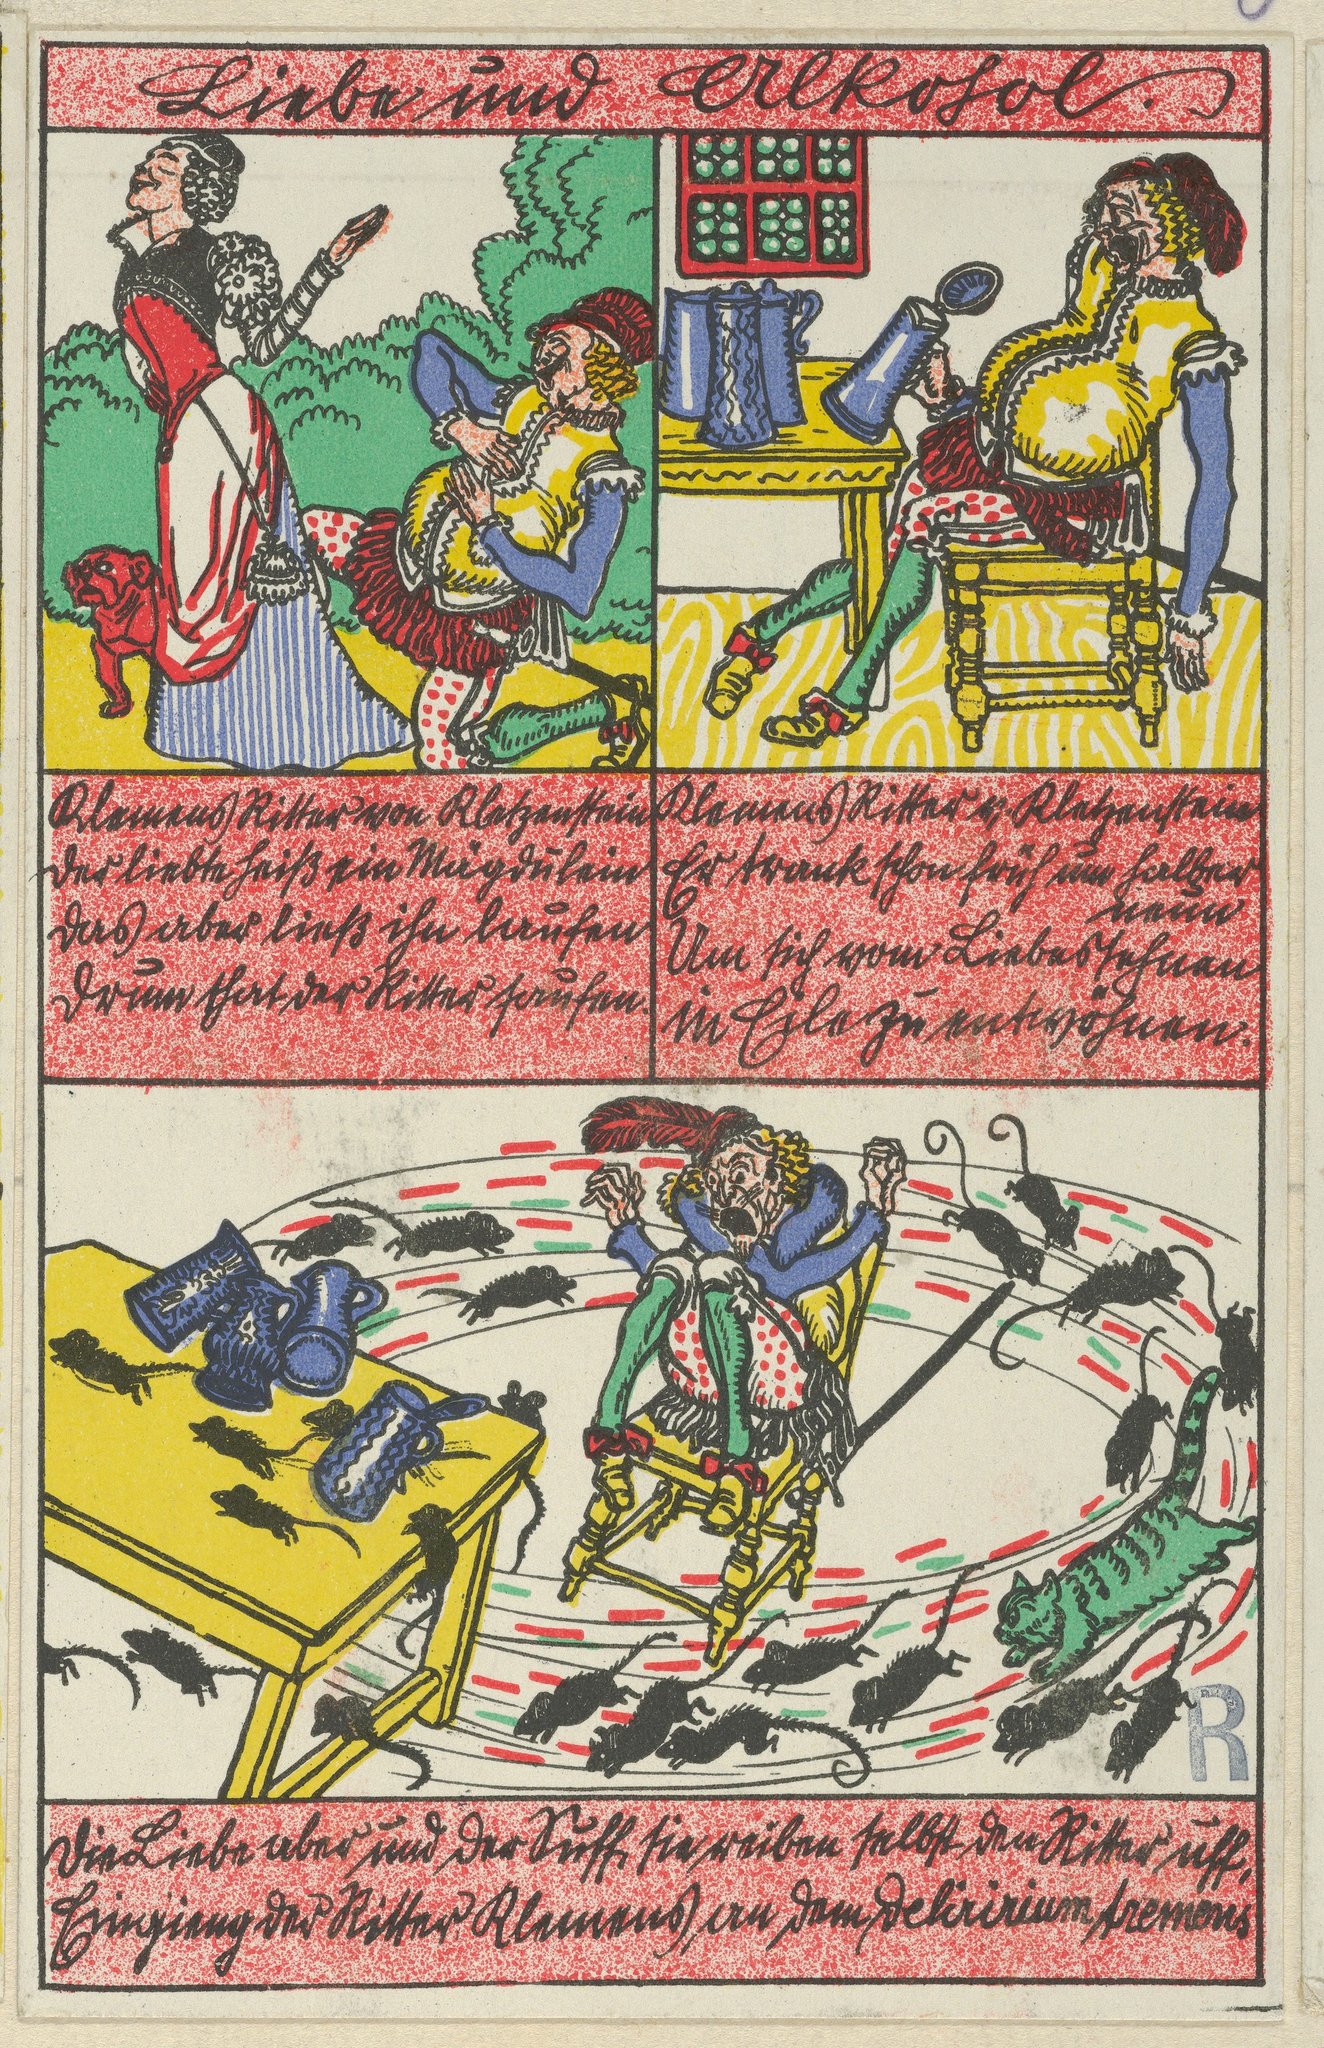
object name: print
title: Love and Alcohol (Liebe und Alkohol)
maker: moriz jung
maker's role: artist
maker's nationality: austrian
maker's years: 1885-1915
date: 1911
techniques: lithograph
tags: satire,fear,men,women,mice,drinking